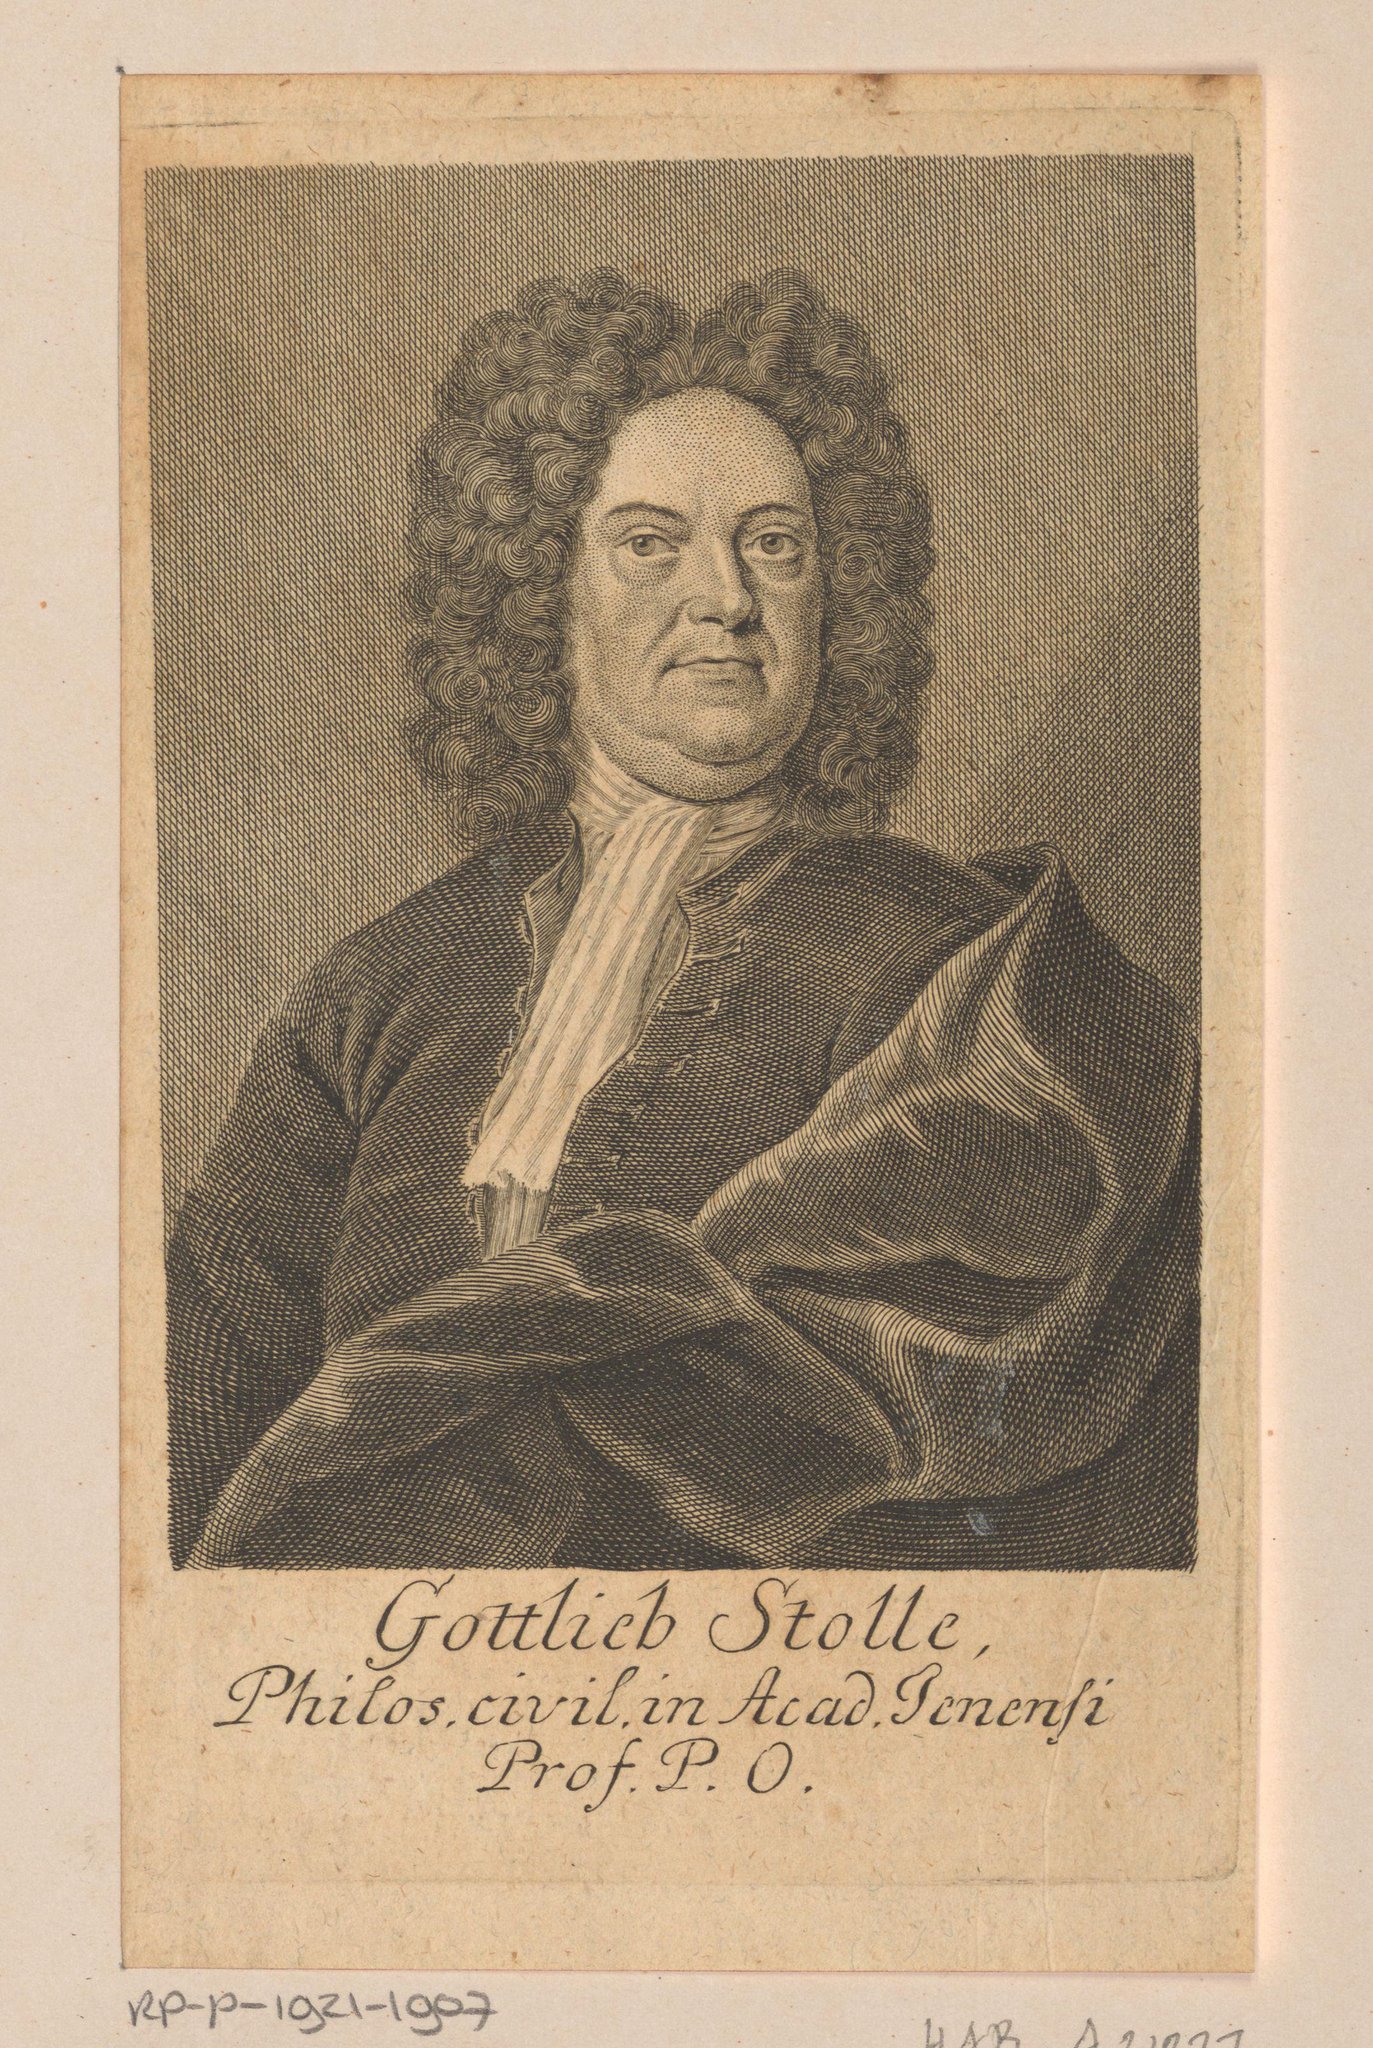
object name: print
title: Portret van Gottlieb Stolle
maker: johann martin bernigeroth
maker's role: print maker, publisher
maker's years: 1713-1767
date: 1728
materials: paper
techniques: engraving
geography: leipzig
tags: historical persons, professor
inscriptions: collector's mark: Lugt 2233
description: Prent waarschijnlijk uit: Deutsche Acta Eruditorum (...). Leipzig: Johann Gottlieb Gleditsch, 1728, dl. 138.